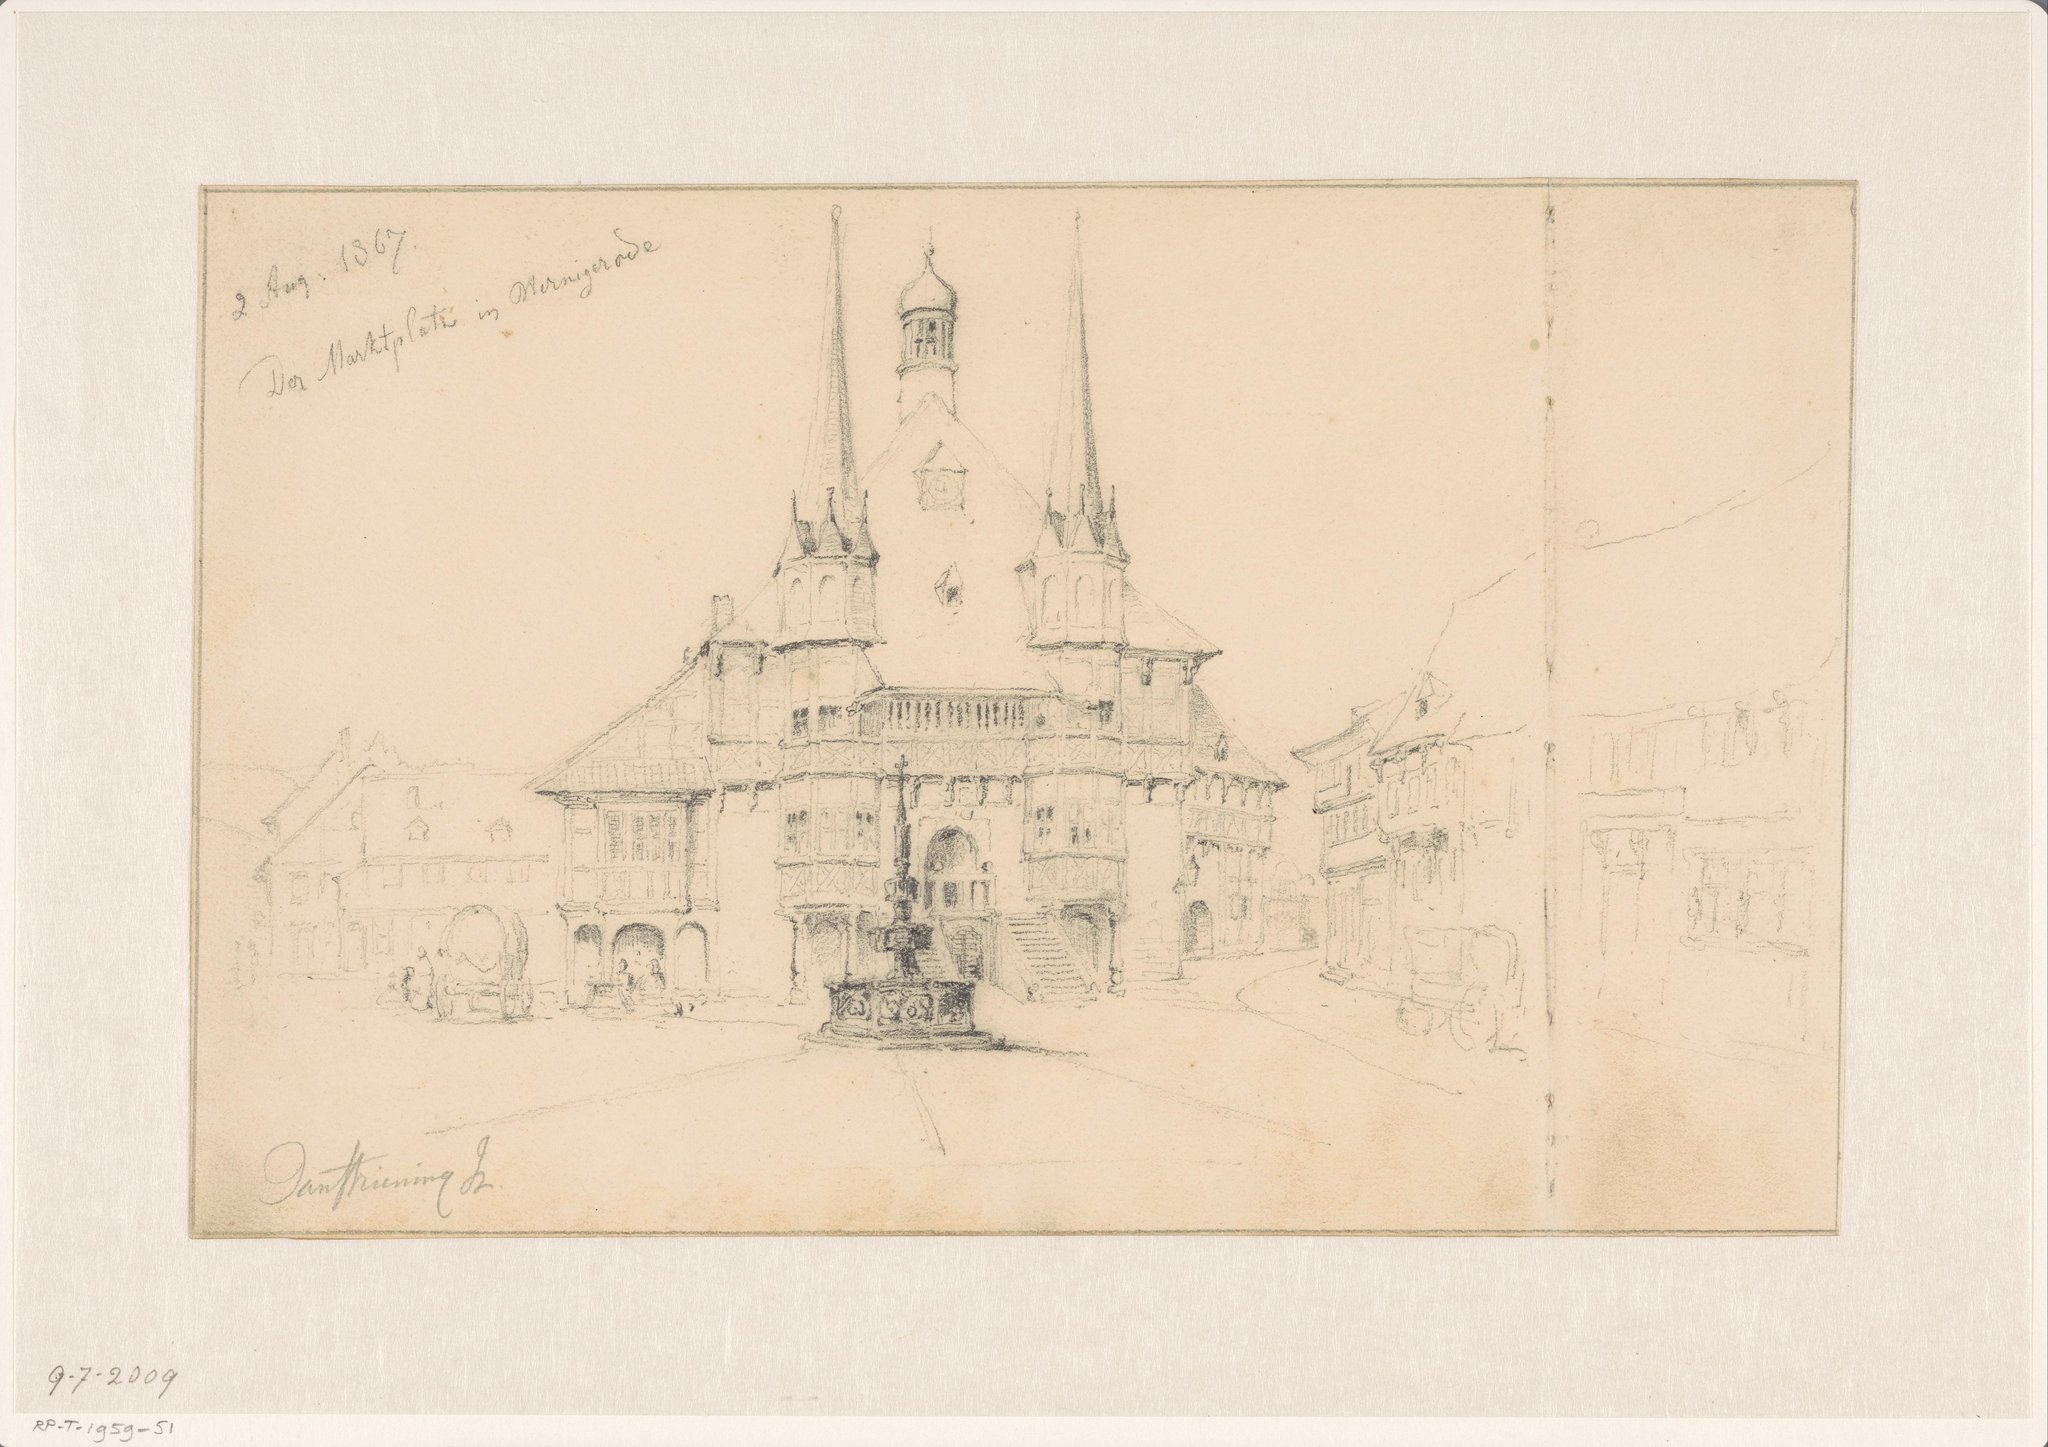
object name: drawing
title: Raadhuis aan het marktplein van Wernigerode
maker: jan striening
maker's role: draughtsman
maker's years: 1827-1903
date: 1867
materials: paper, pencil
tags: square, place, circus, etc., townhall